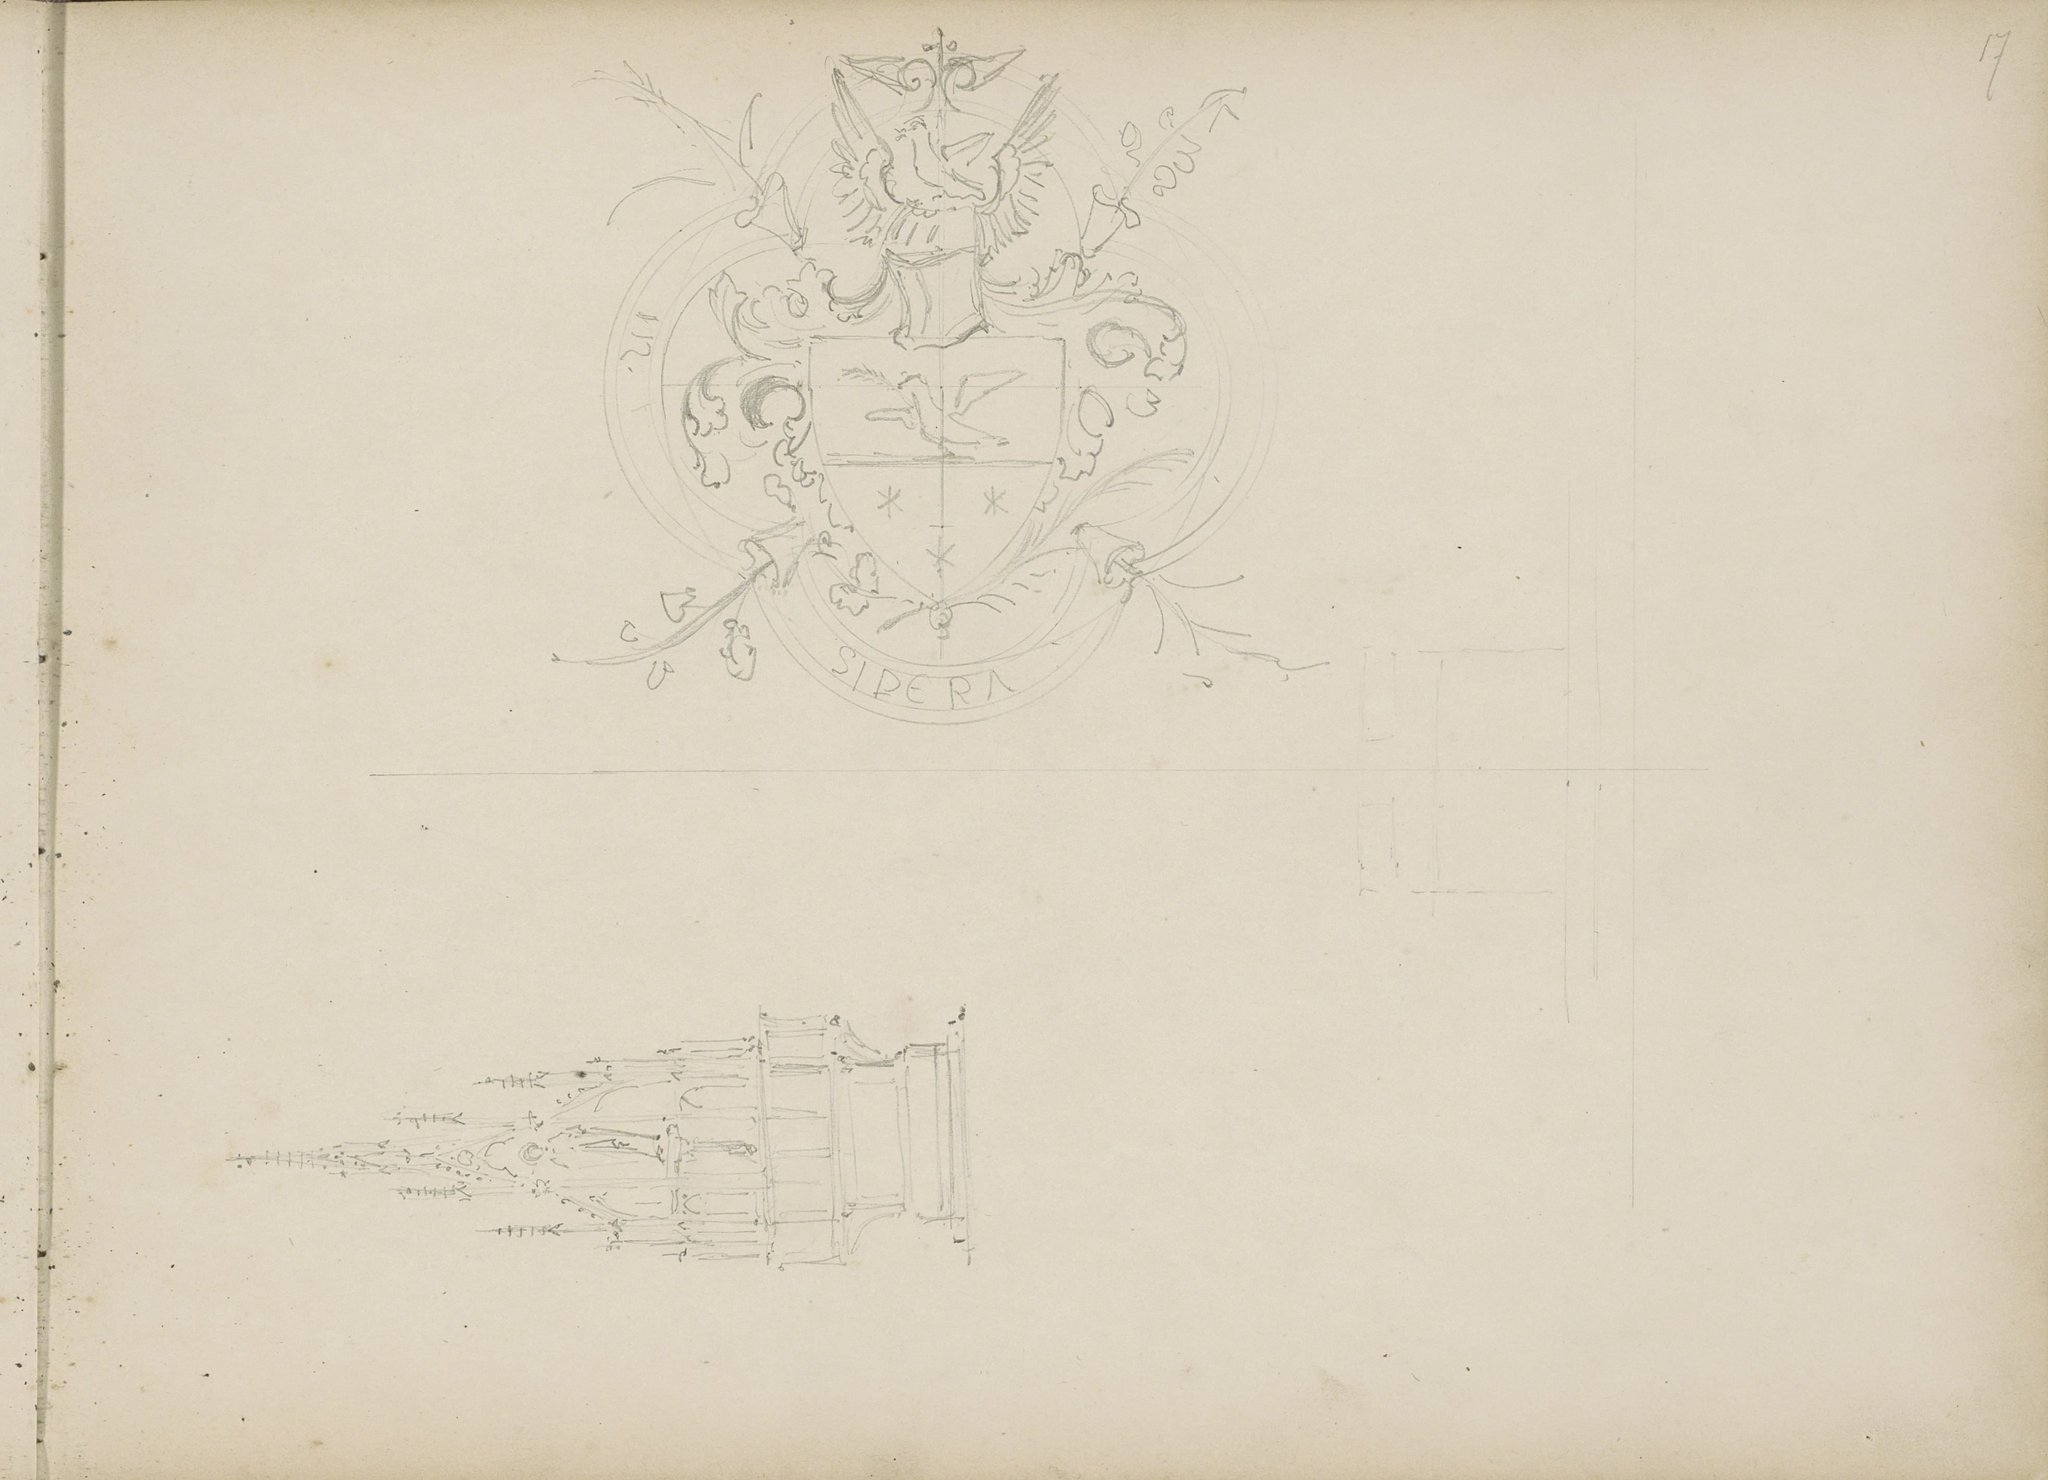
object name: sketchbook leaf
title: Altaar en een familiewapen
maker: pierre joseph hubert cuypers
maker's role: draughtsman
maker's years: 1827-1921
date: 1857-1859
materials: paper, pencil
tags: altar, armorial bearing, heraldry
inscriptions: annotation: ‘SIDERA’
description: Het wapen toont een vredesduif, drie sterren en een gevleugelde helm. Blad 17 recto uit een schetsboek met 77 bladen.